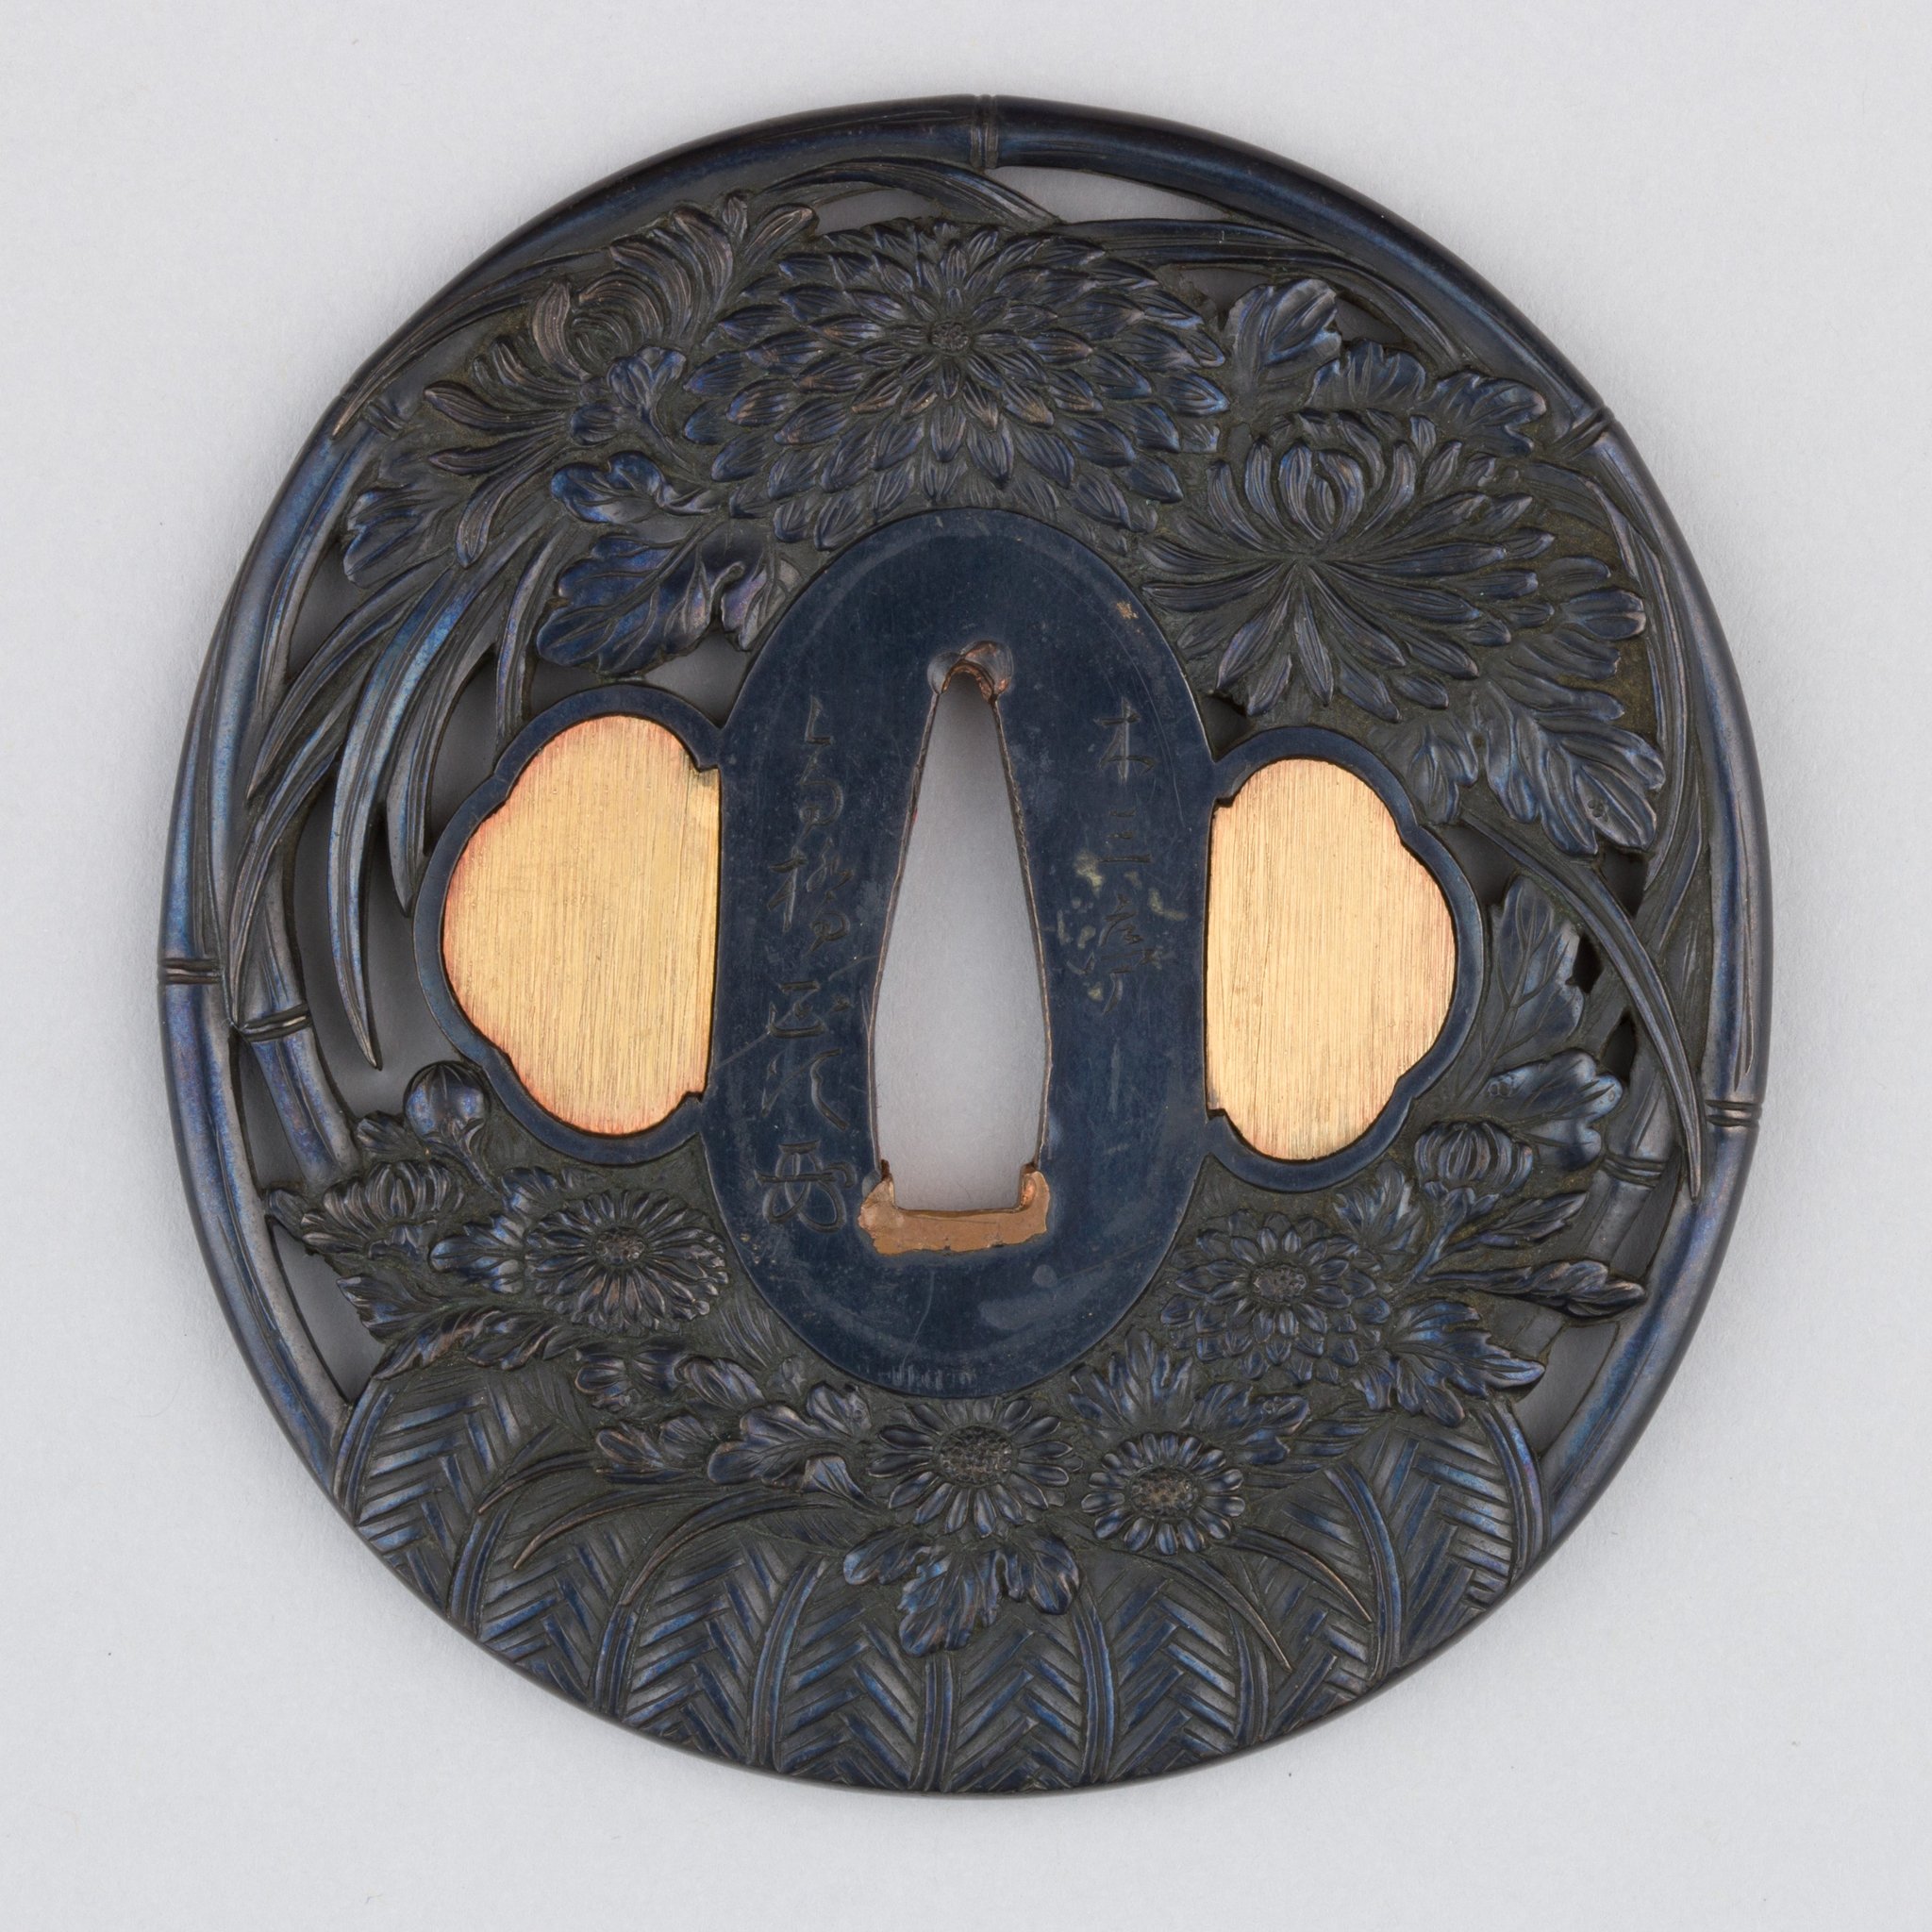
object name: sword guard tsuba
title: Sword guard (Tsuba) with Flower Basket Motif (花籠図鐔)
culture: japanese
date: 1615-1868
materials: copper, gold alloy, gold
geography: japan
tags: flowers